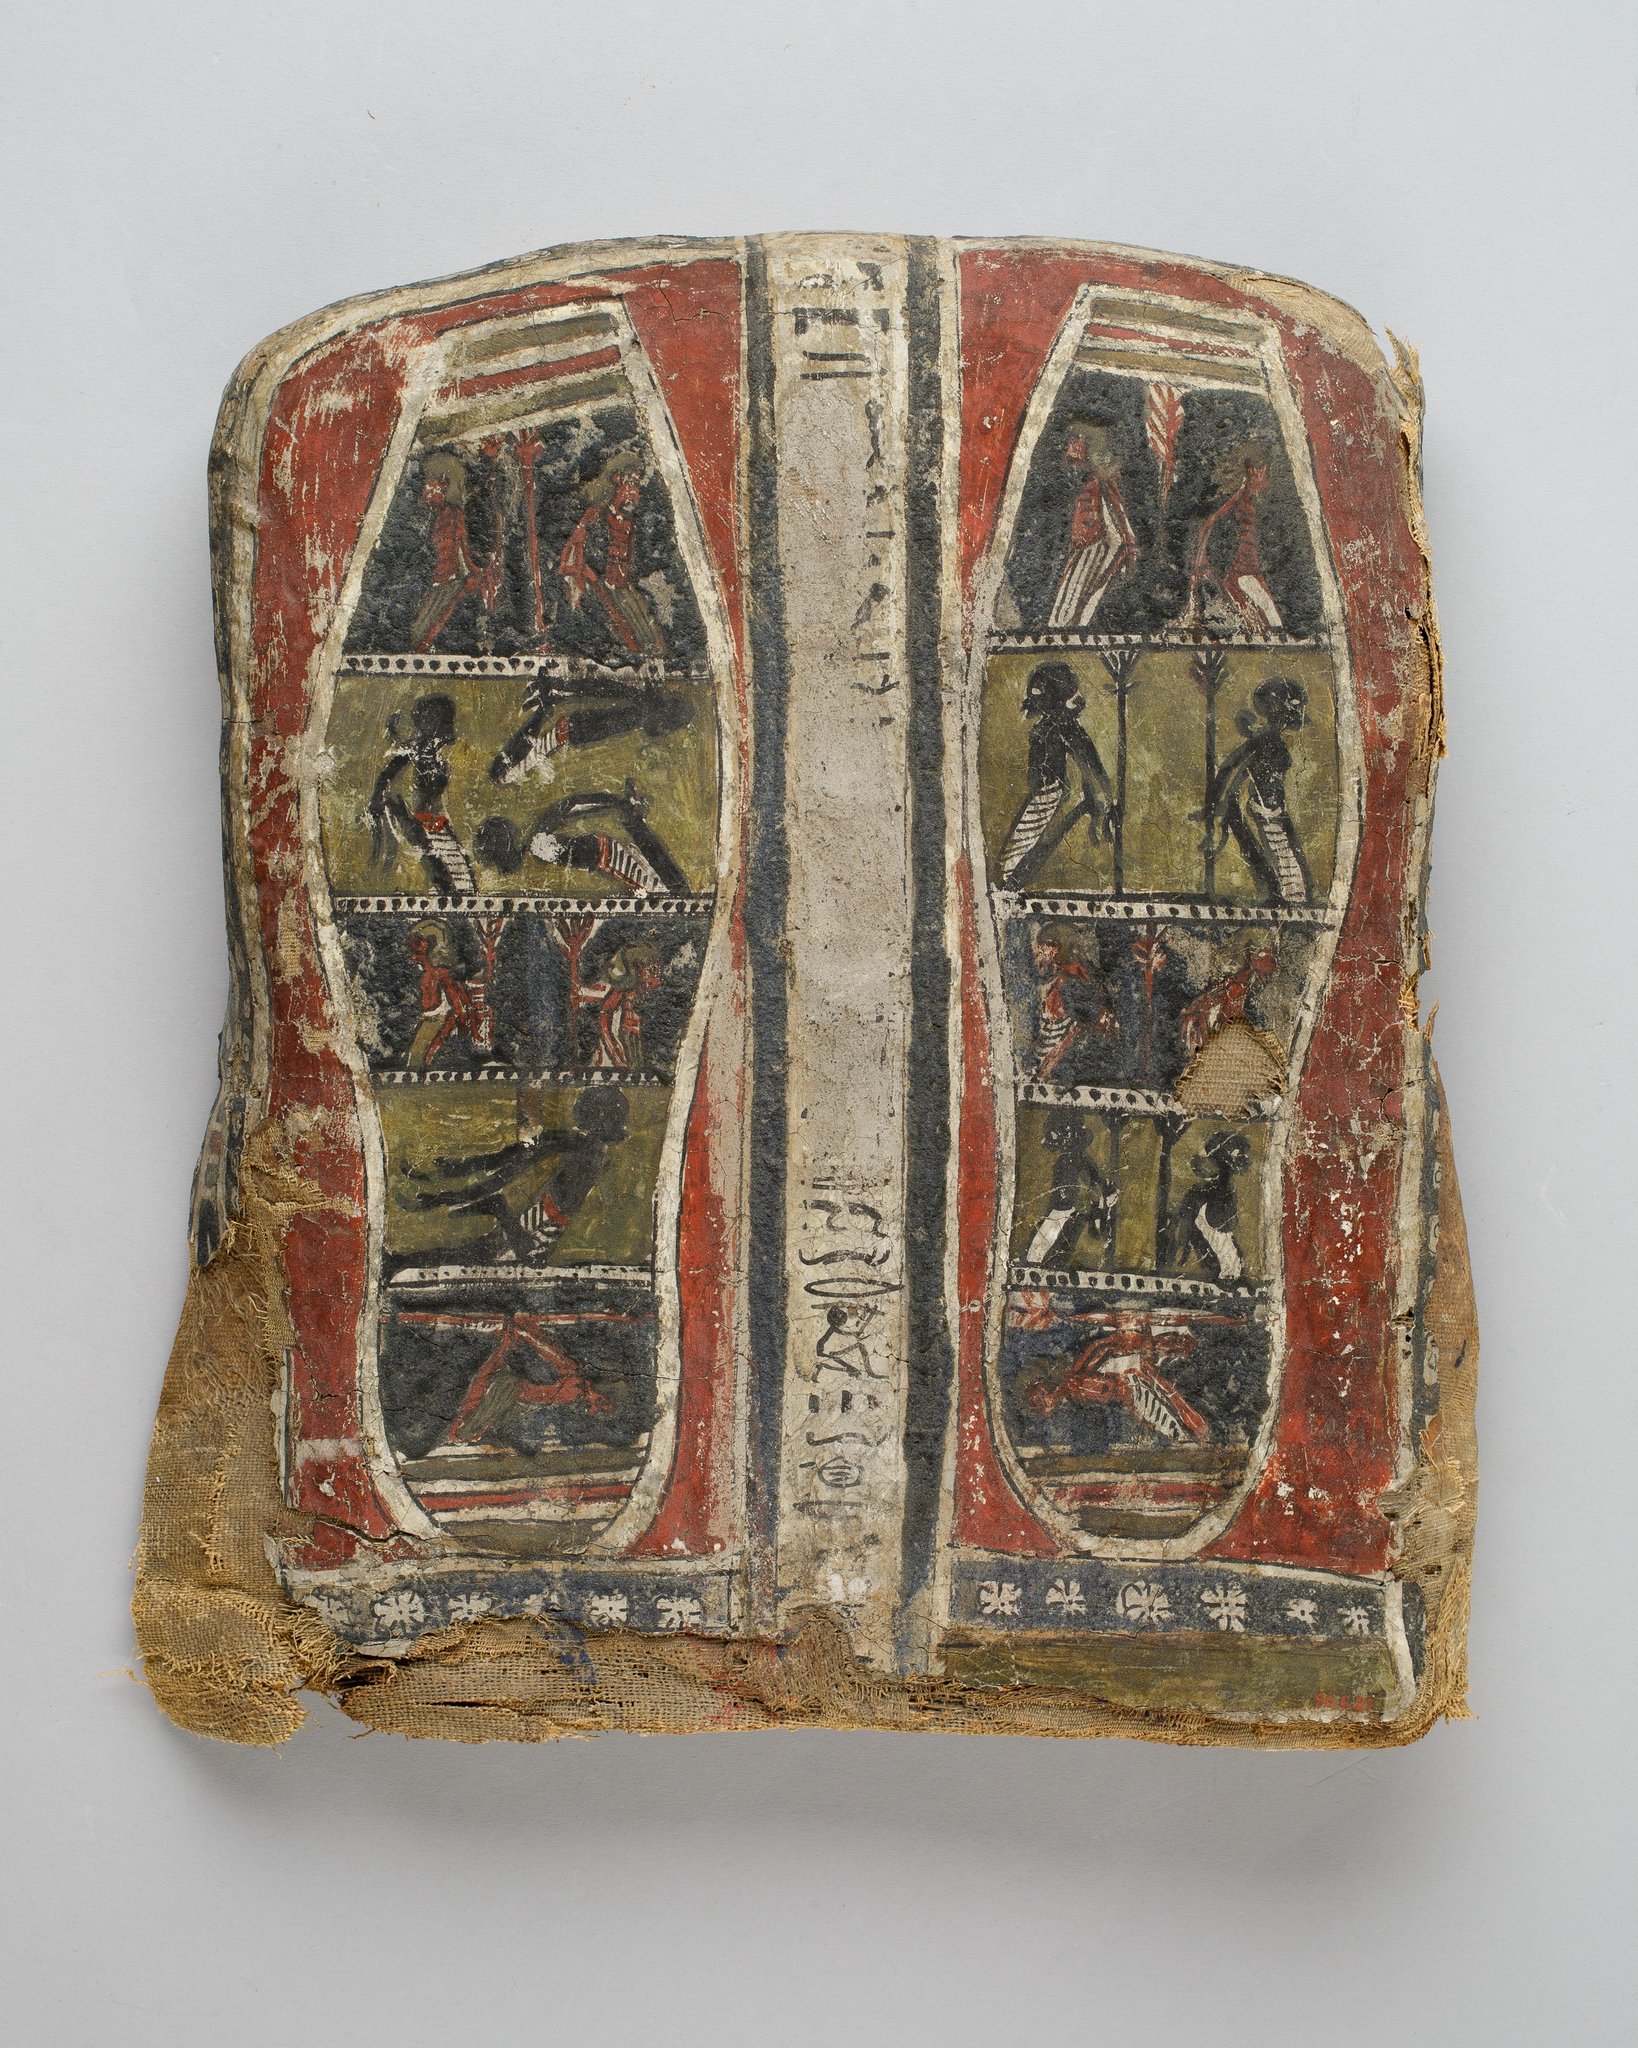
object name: cartonnage footboard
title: Footboard from a cartonnage case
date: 400-1 BCE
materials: linen, paint, paste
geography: egypt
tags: human figures,prisoners